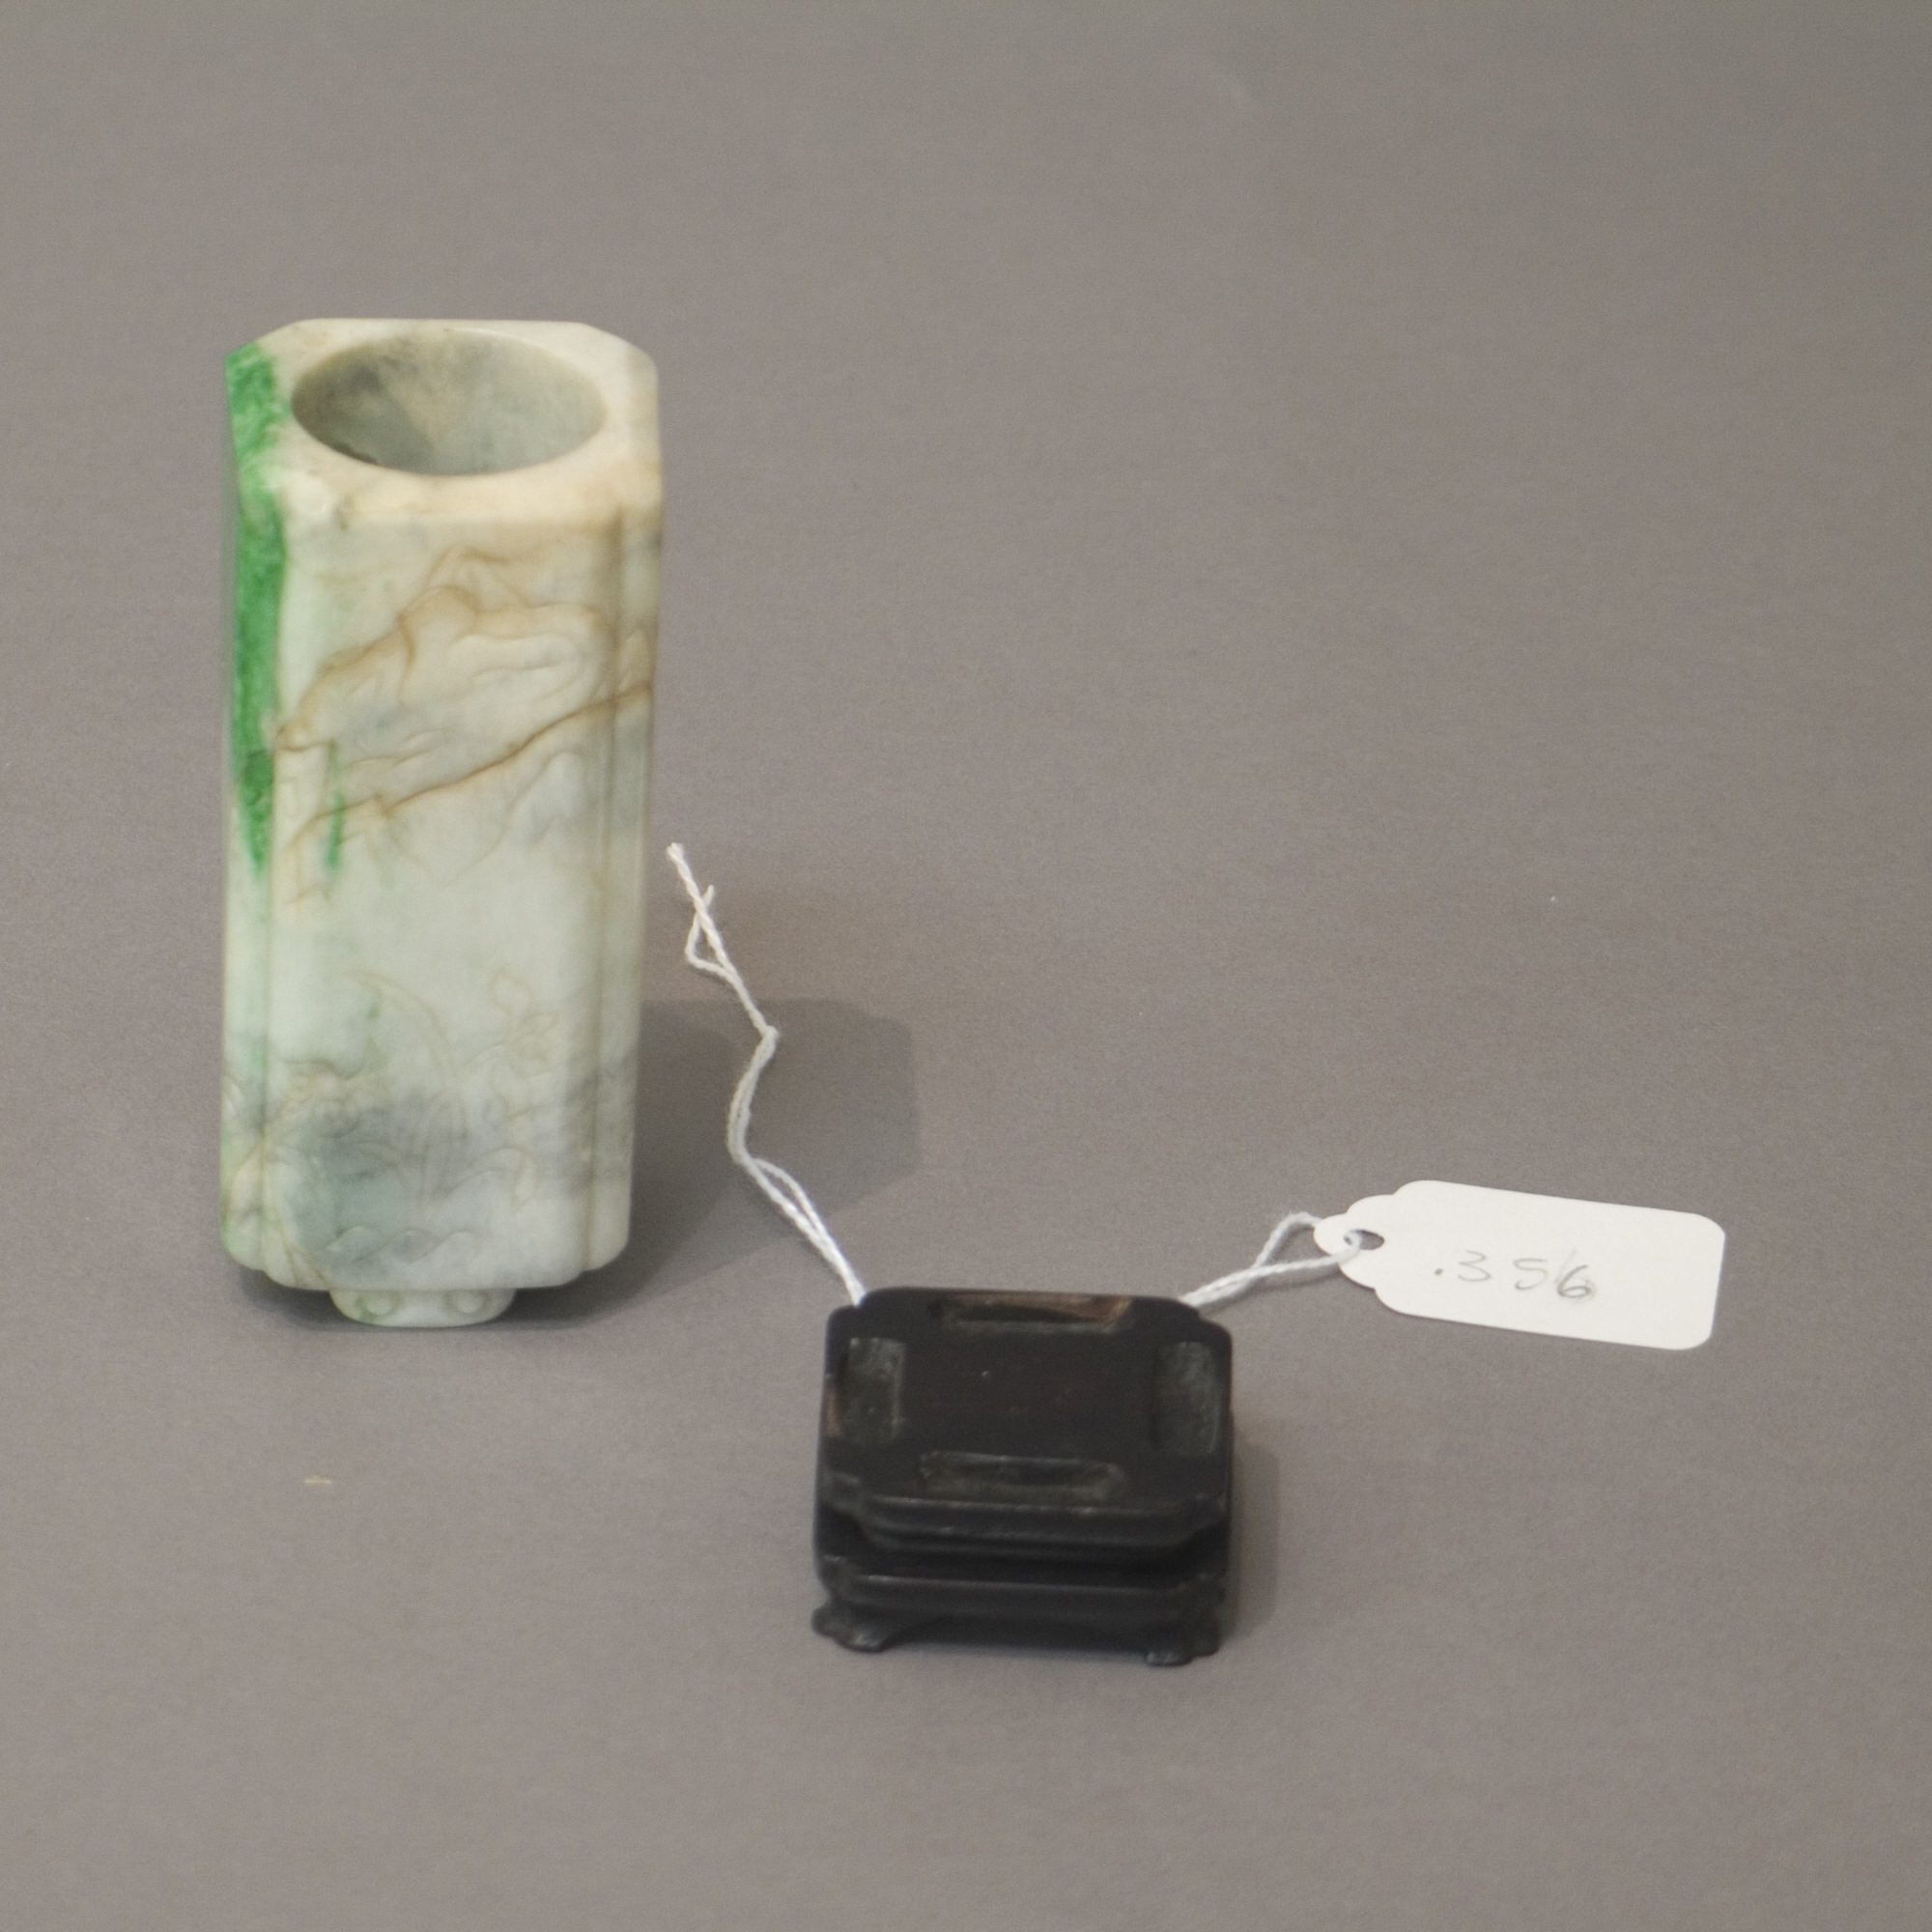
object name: vase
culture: chinese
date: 1368-1644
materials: jade